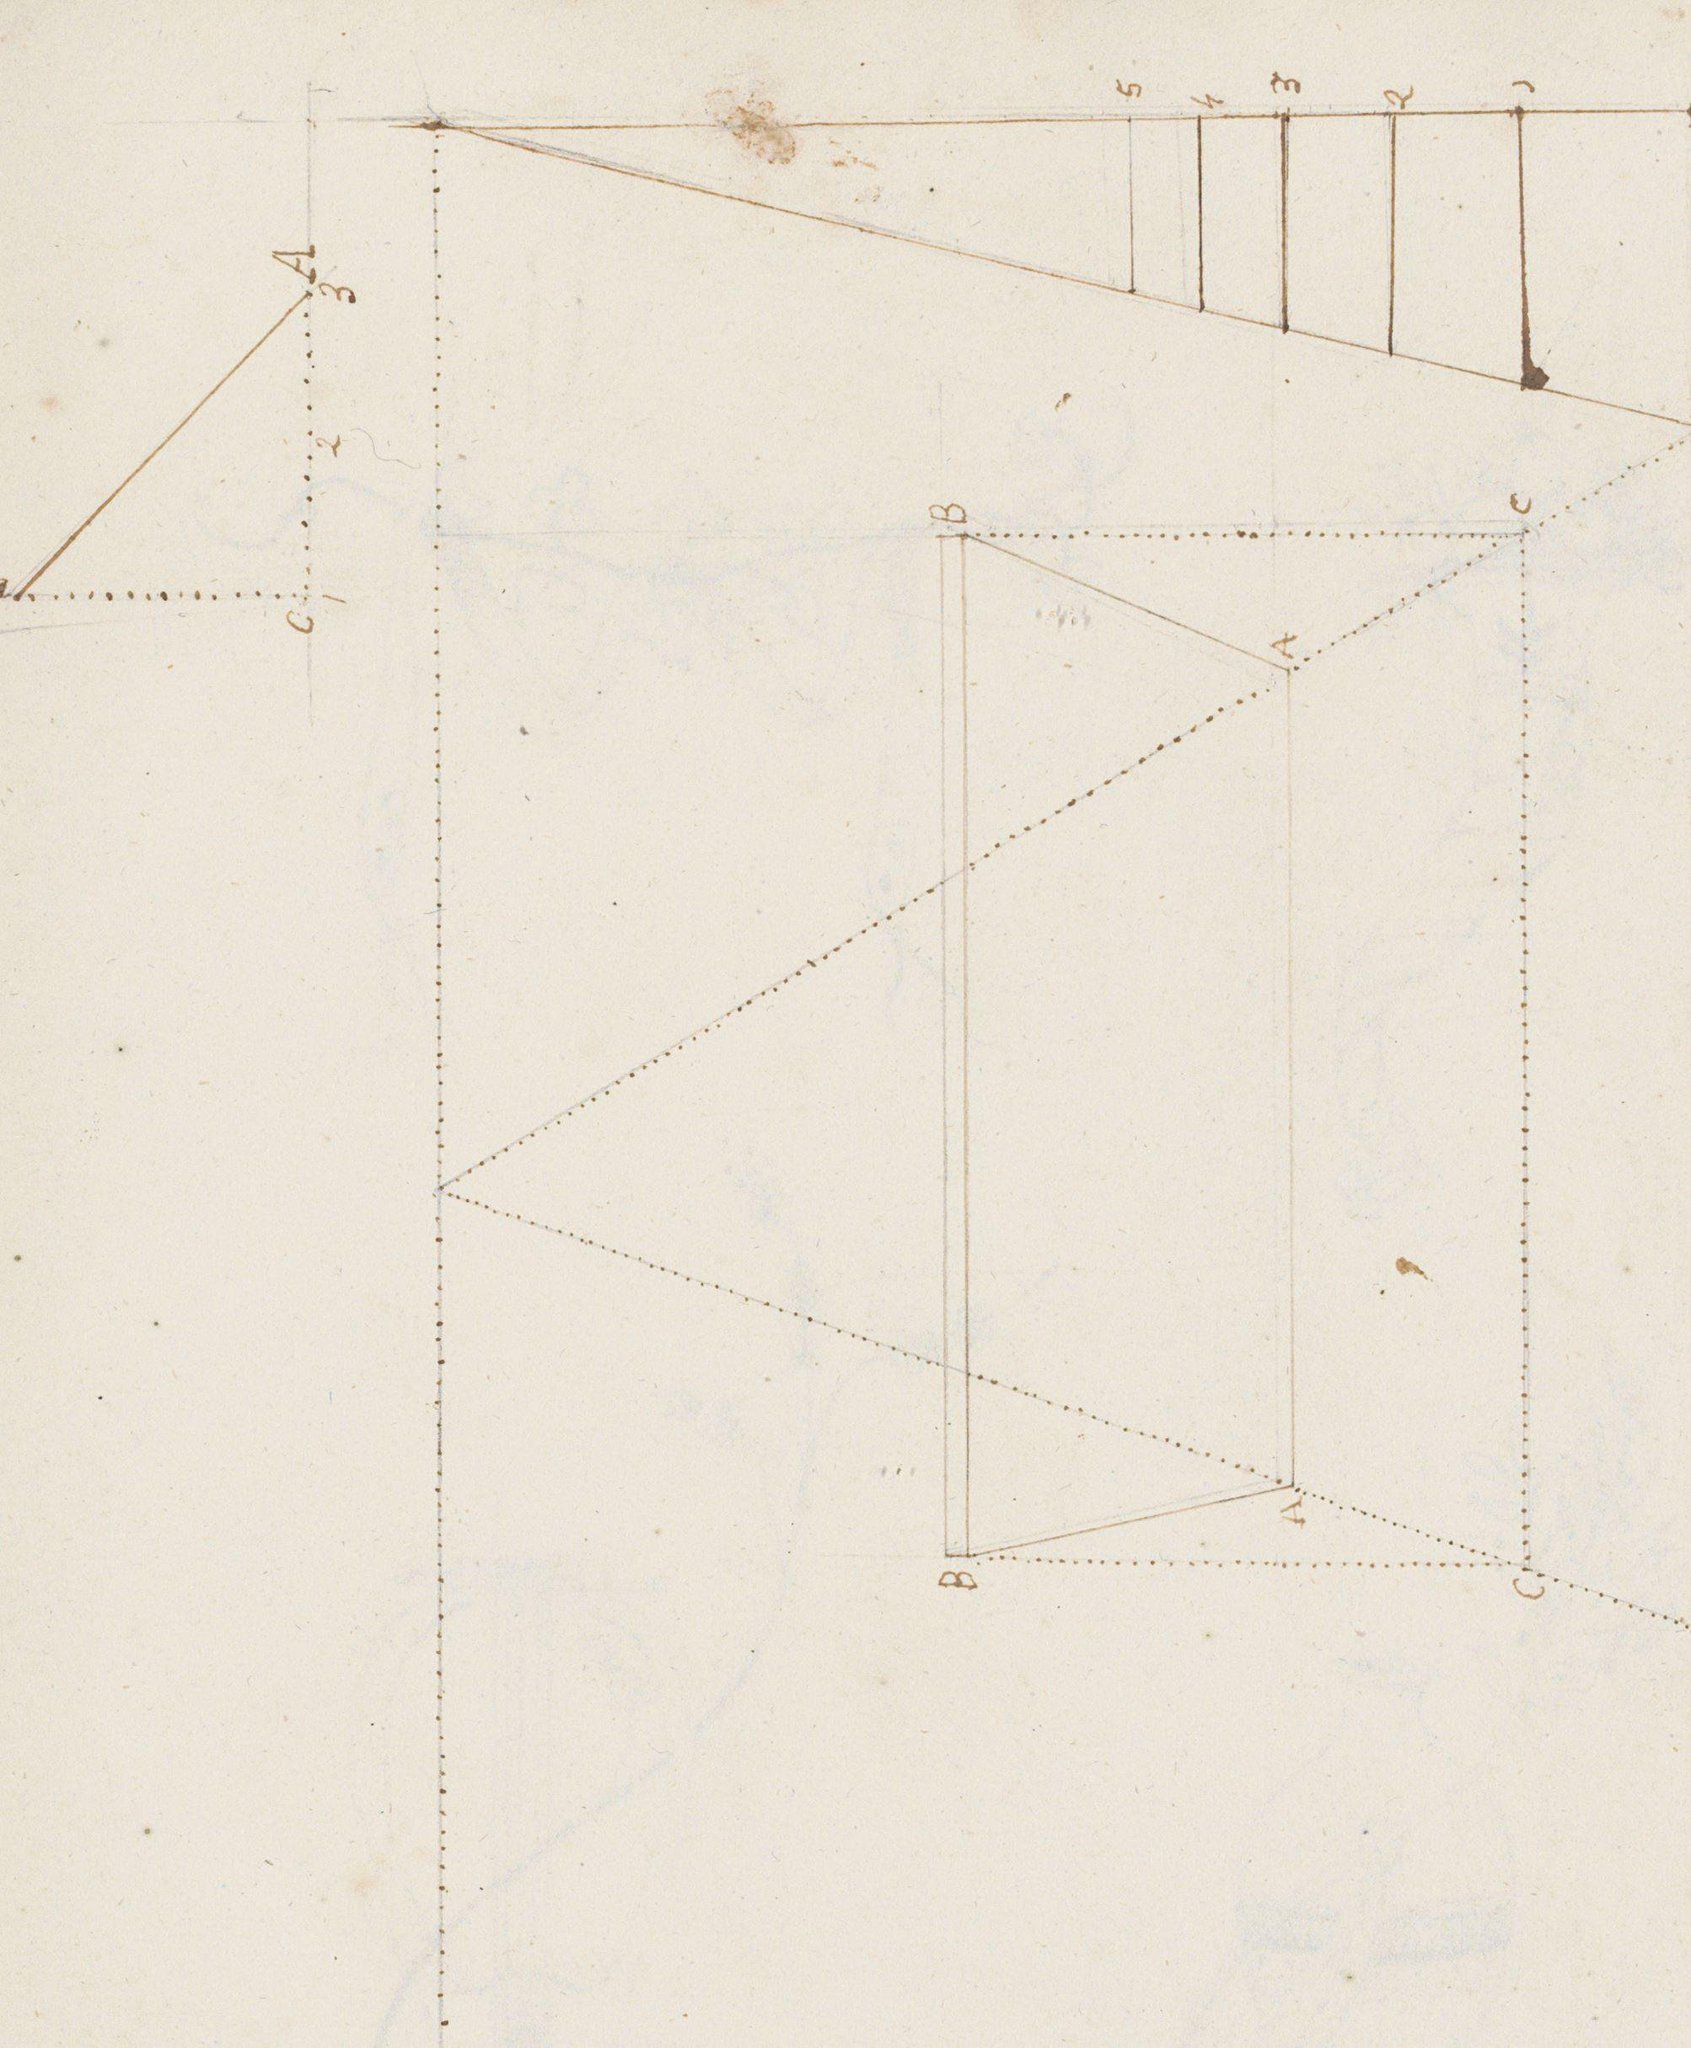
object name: sketchbook leaf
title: Perspectiefoefening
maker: jonkvrouw catharina kemper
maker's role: draughtsman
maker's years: 1801-1871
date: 1813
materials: ink, paper, pencil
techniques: pen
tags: mathematical perspective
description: Blad 13 recto uit een schetsboek met 91 bladen.